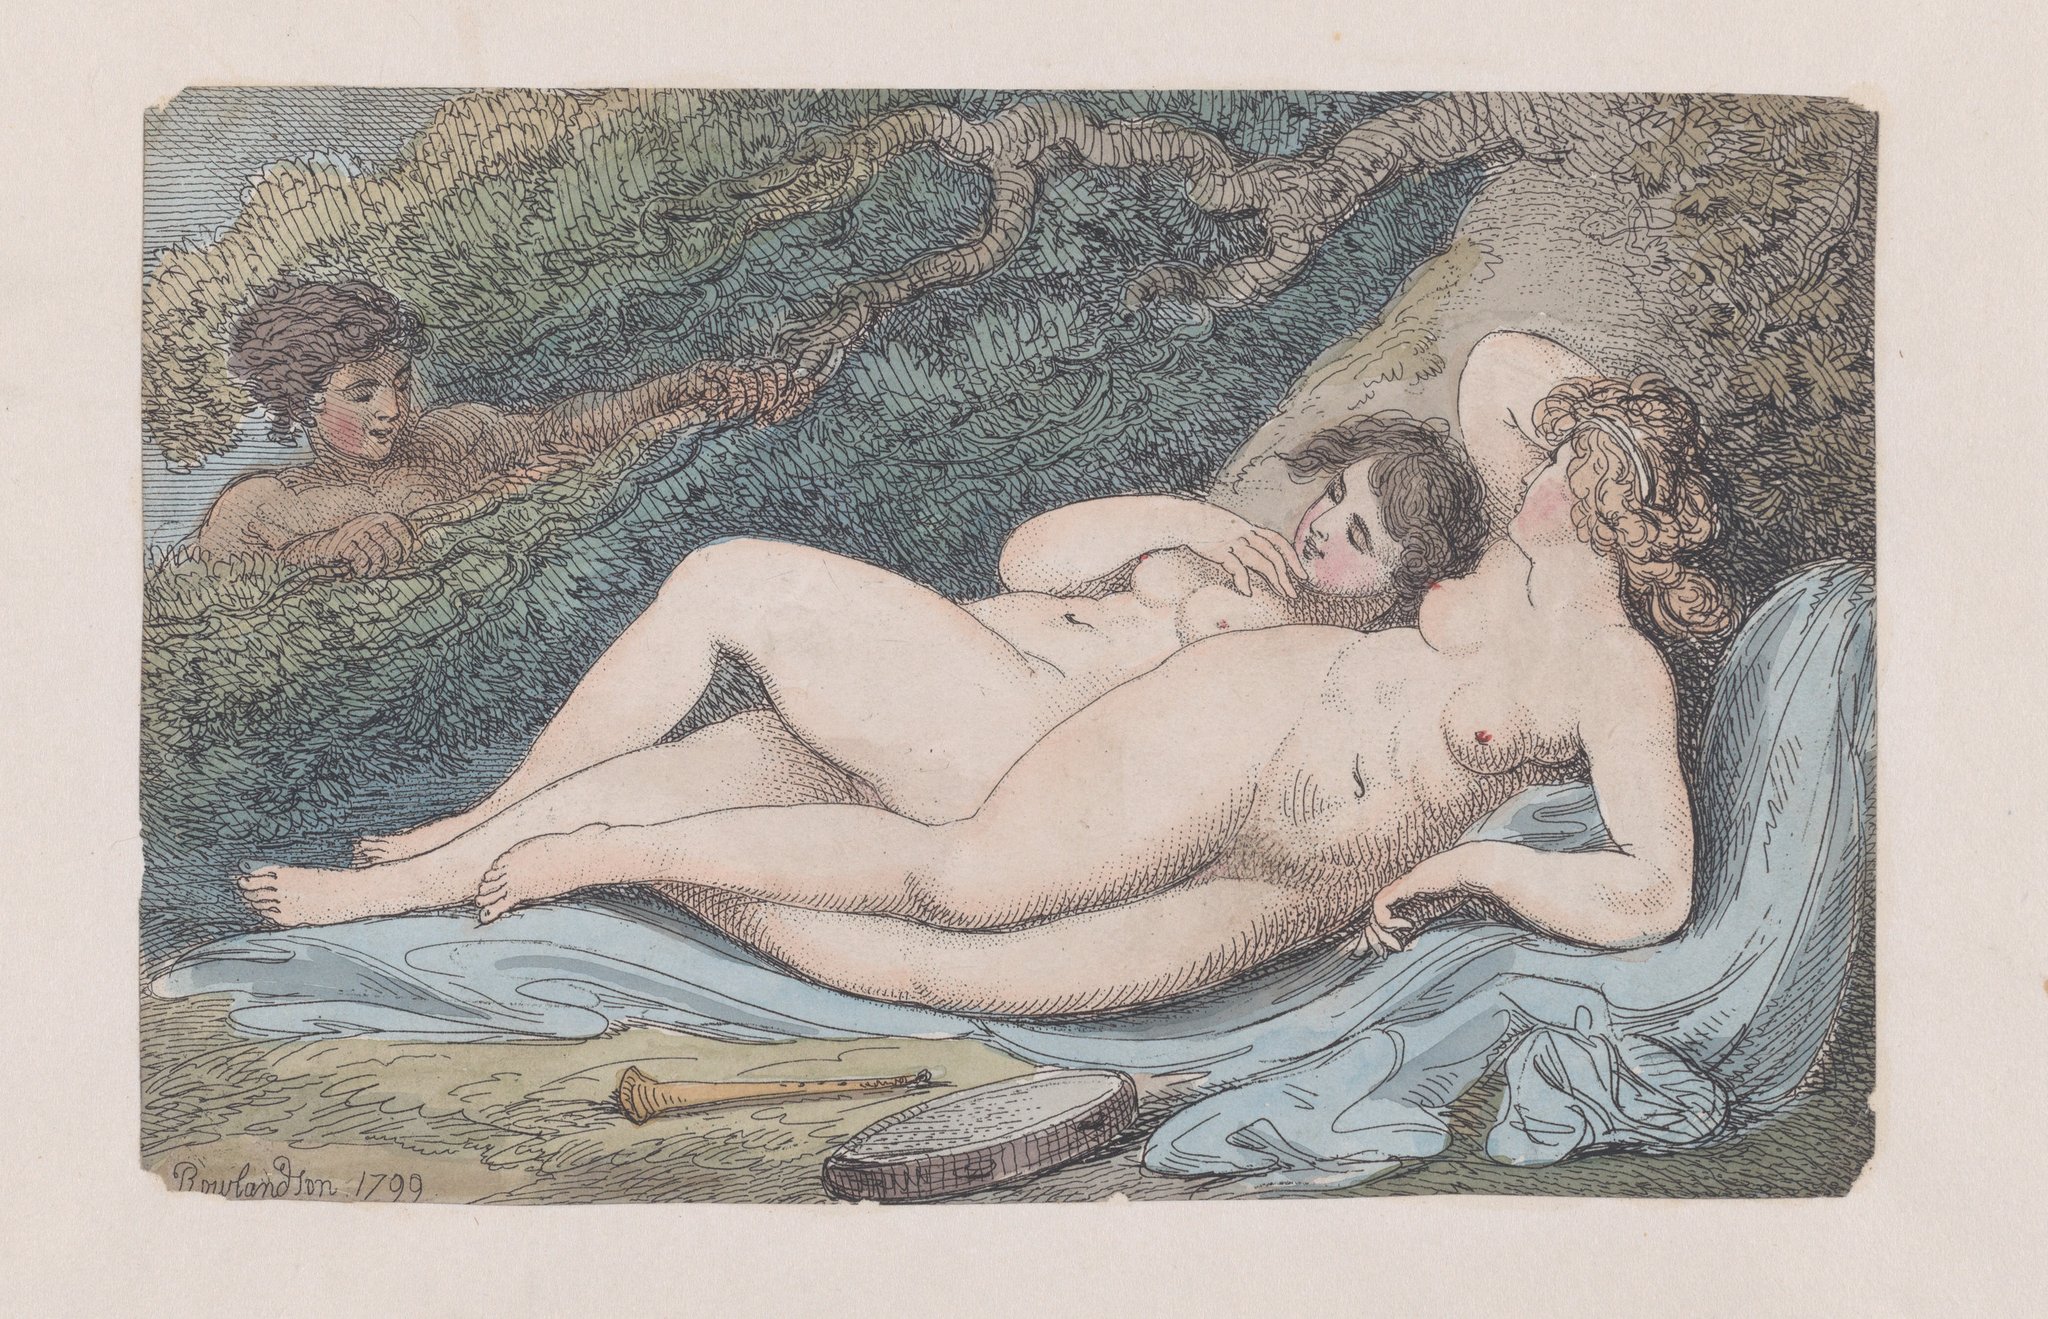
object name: print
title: Wood-Nymphs (The Discovery)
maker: thomas rowlandson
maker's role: artist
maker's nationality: british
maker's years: 1757-1827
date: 1799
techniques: etching, stippling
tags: female nudes,nymphs